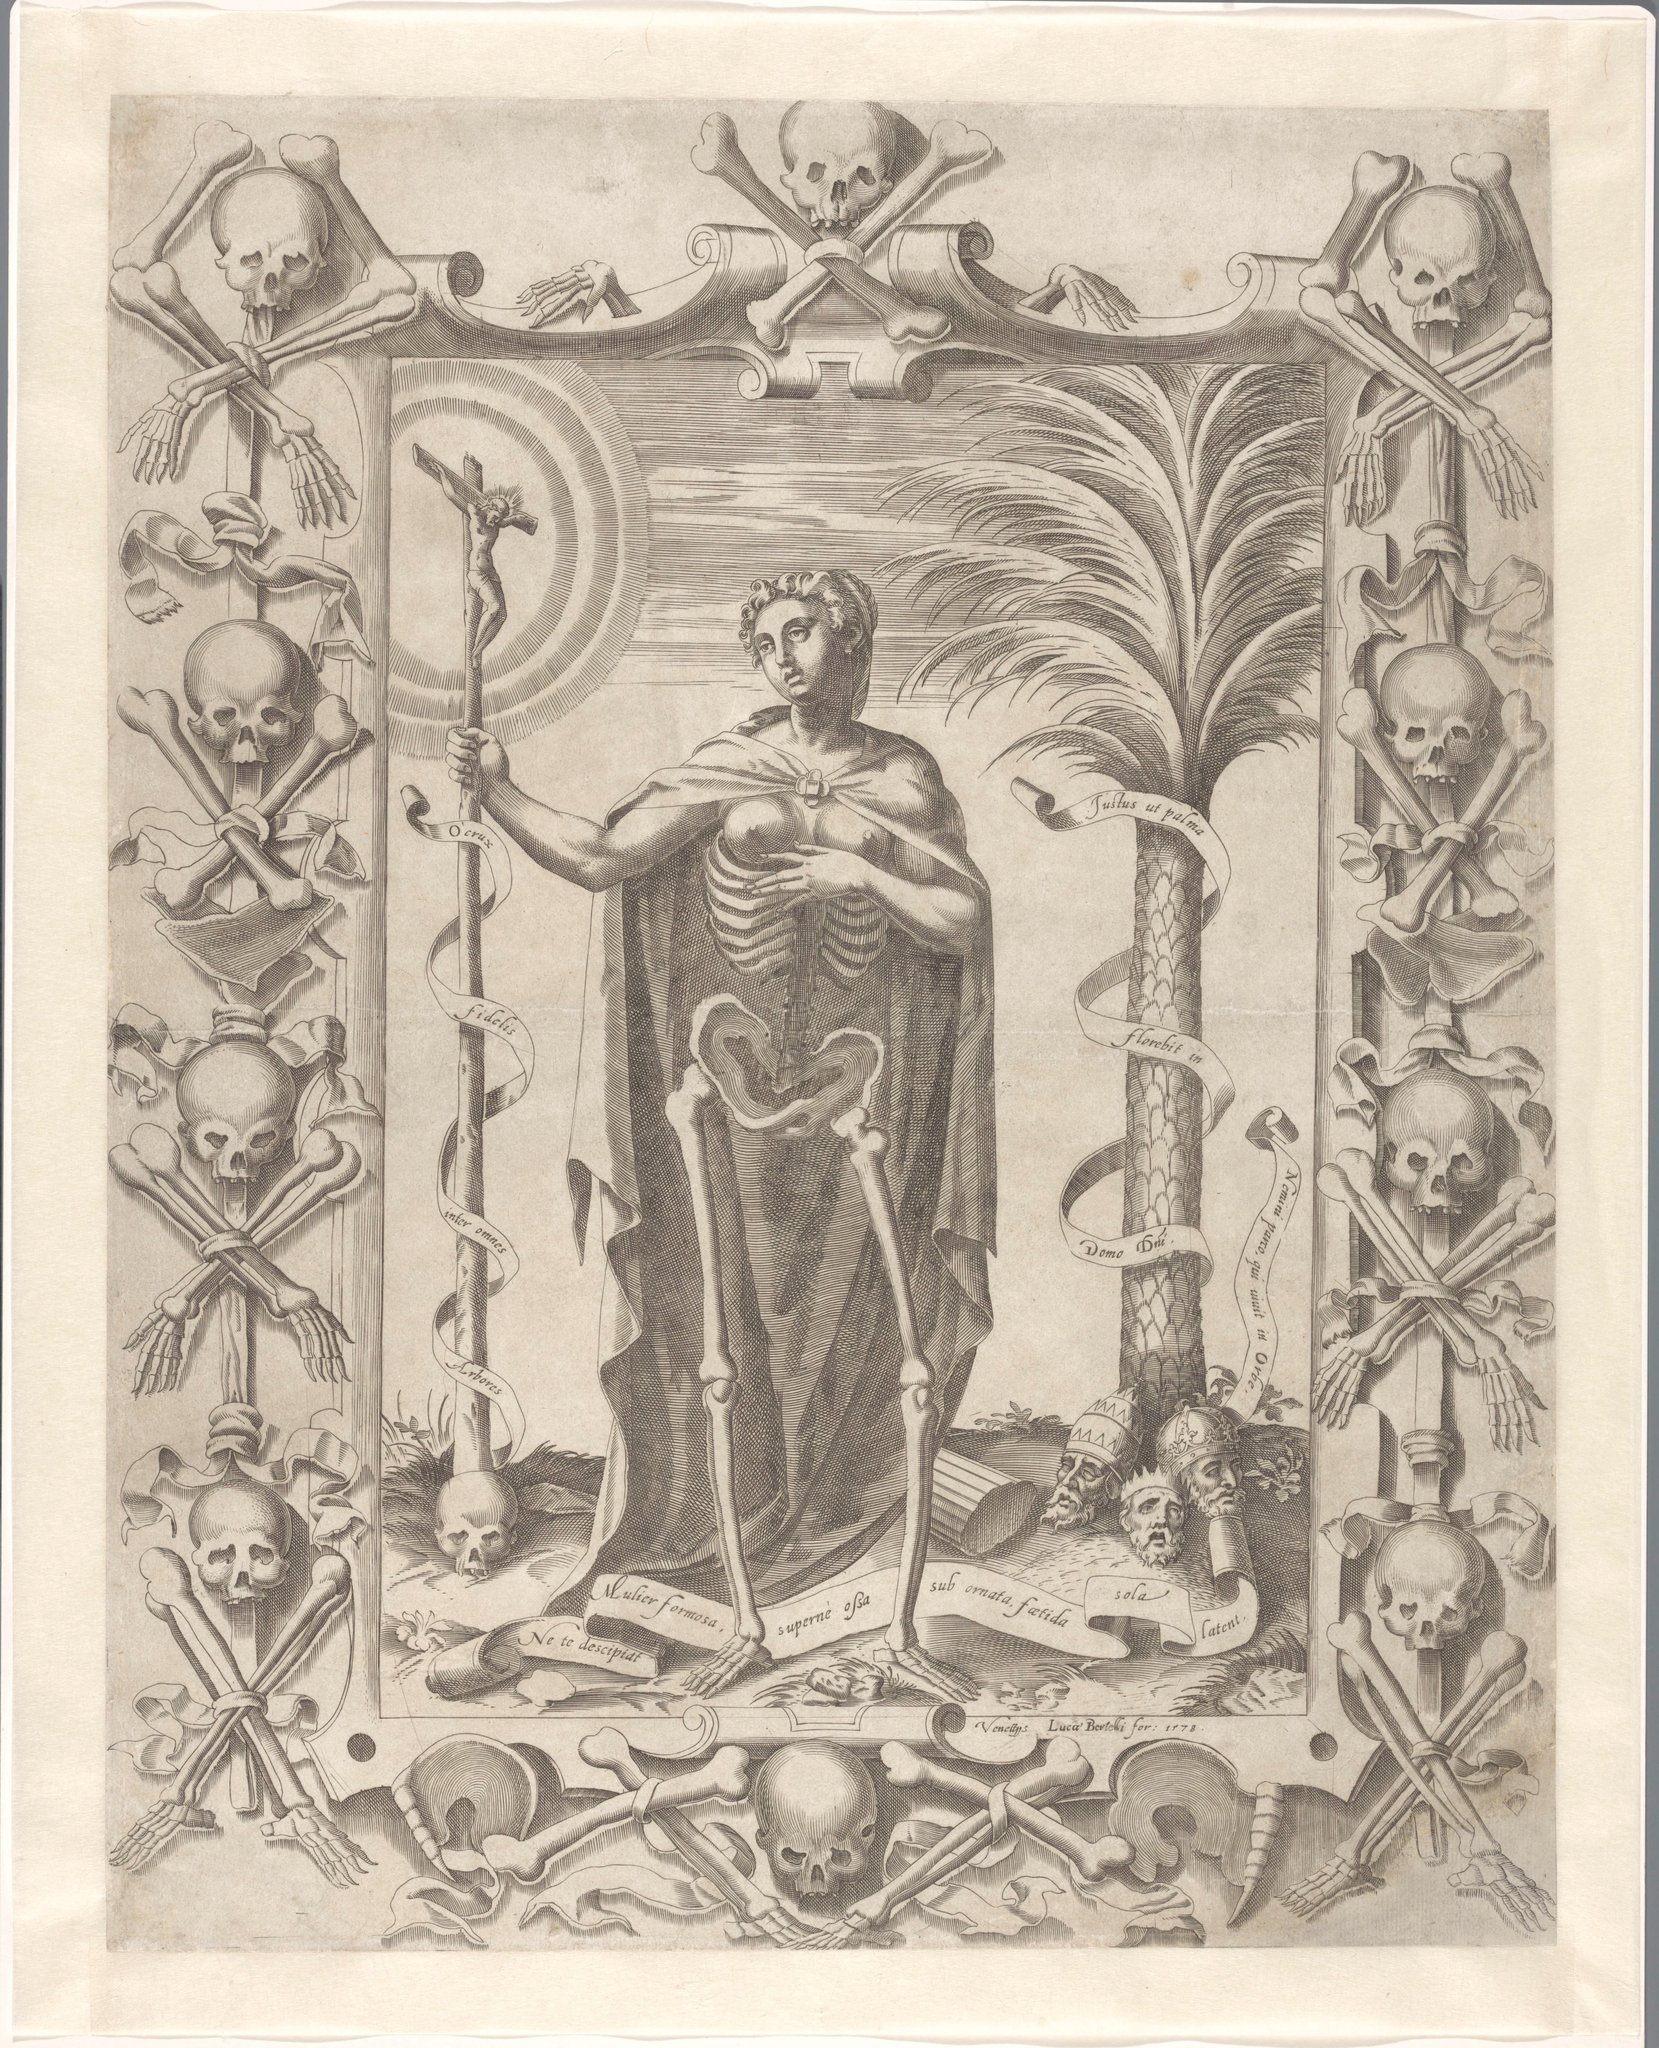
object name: print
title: Vanitas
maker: luca bertelli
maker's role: bookseller, print maker, publisher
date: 1578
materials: paper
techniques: engraving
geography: venice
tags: (personifications of) 'vanitas', the vanity of human life; fragilità humana, fugacità delle grandezze & della gloria mondana, meditatione della morte, opera vana, piacere vano, vana gloria, vanità (ripa), death as skeleton, death as man, skull as symbol of 'vanitas'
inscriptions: collector's mark: Lugt 2228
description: Allegorie op de dood. De mens, half lichaam en half geraamte, staande met een staf met kruisbeeld in de hand. Rechts een palmboom aan de voet waarvan de hoofden liggen van een paus, koning in keizer. Binnen een omlijsting van schedels en beenderen.